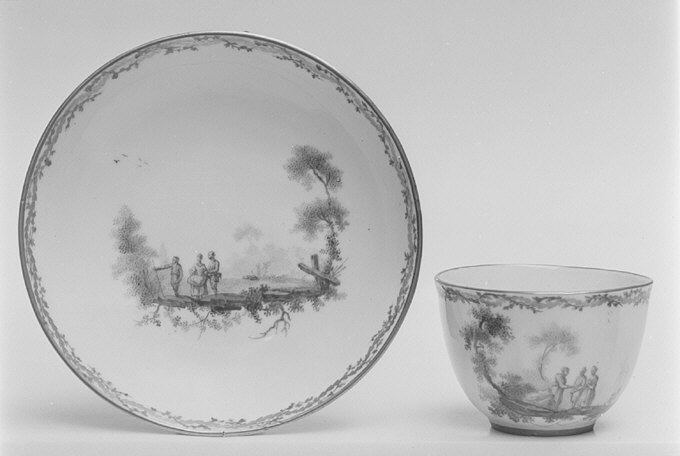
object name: teabowl and saucer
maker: loosdrecht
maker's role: factory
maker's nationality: dutch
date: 1780-1784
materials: hard paste porcelain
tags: men,women,trees